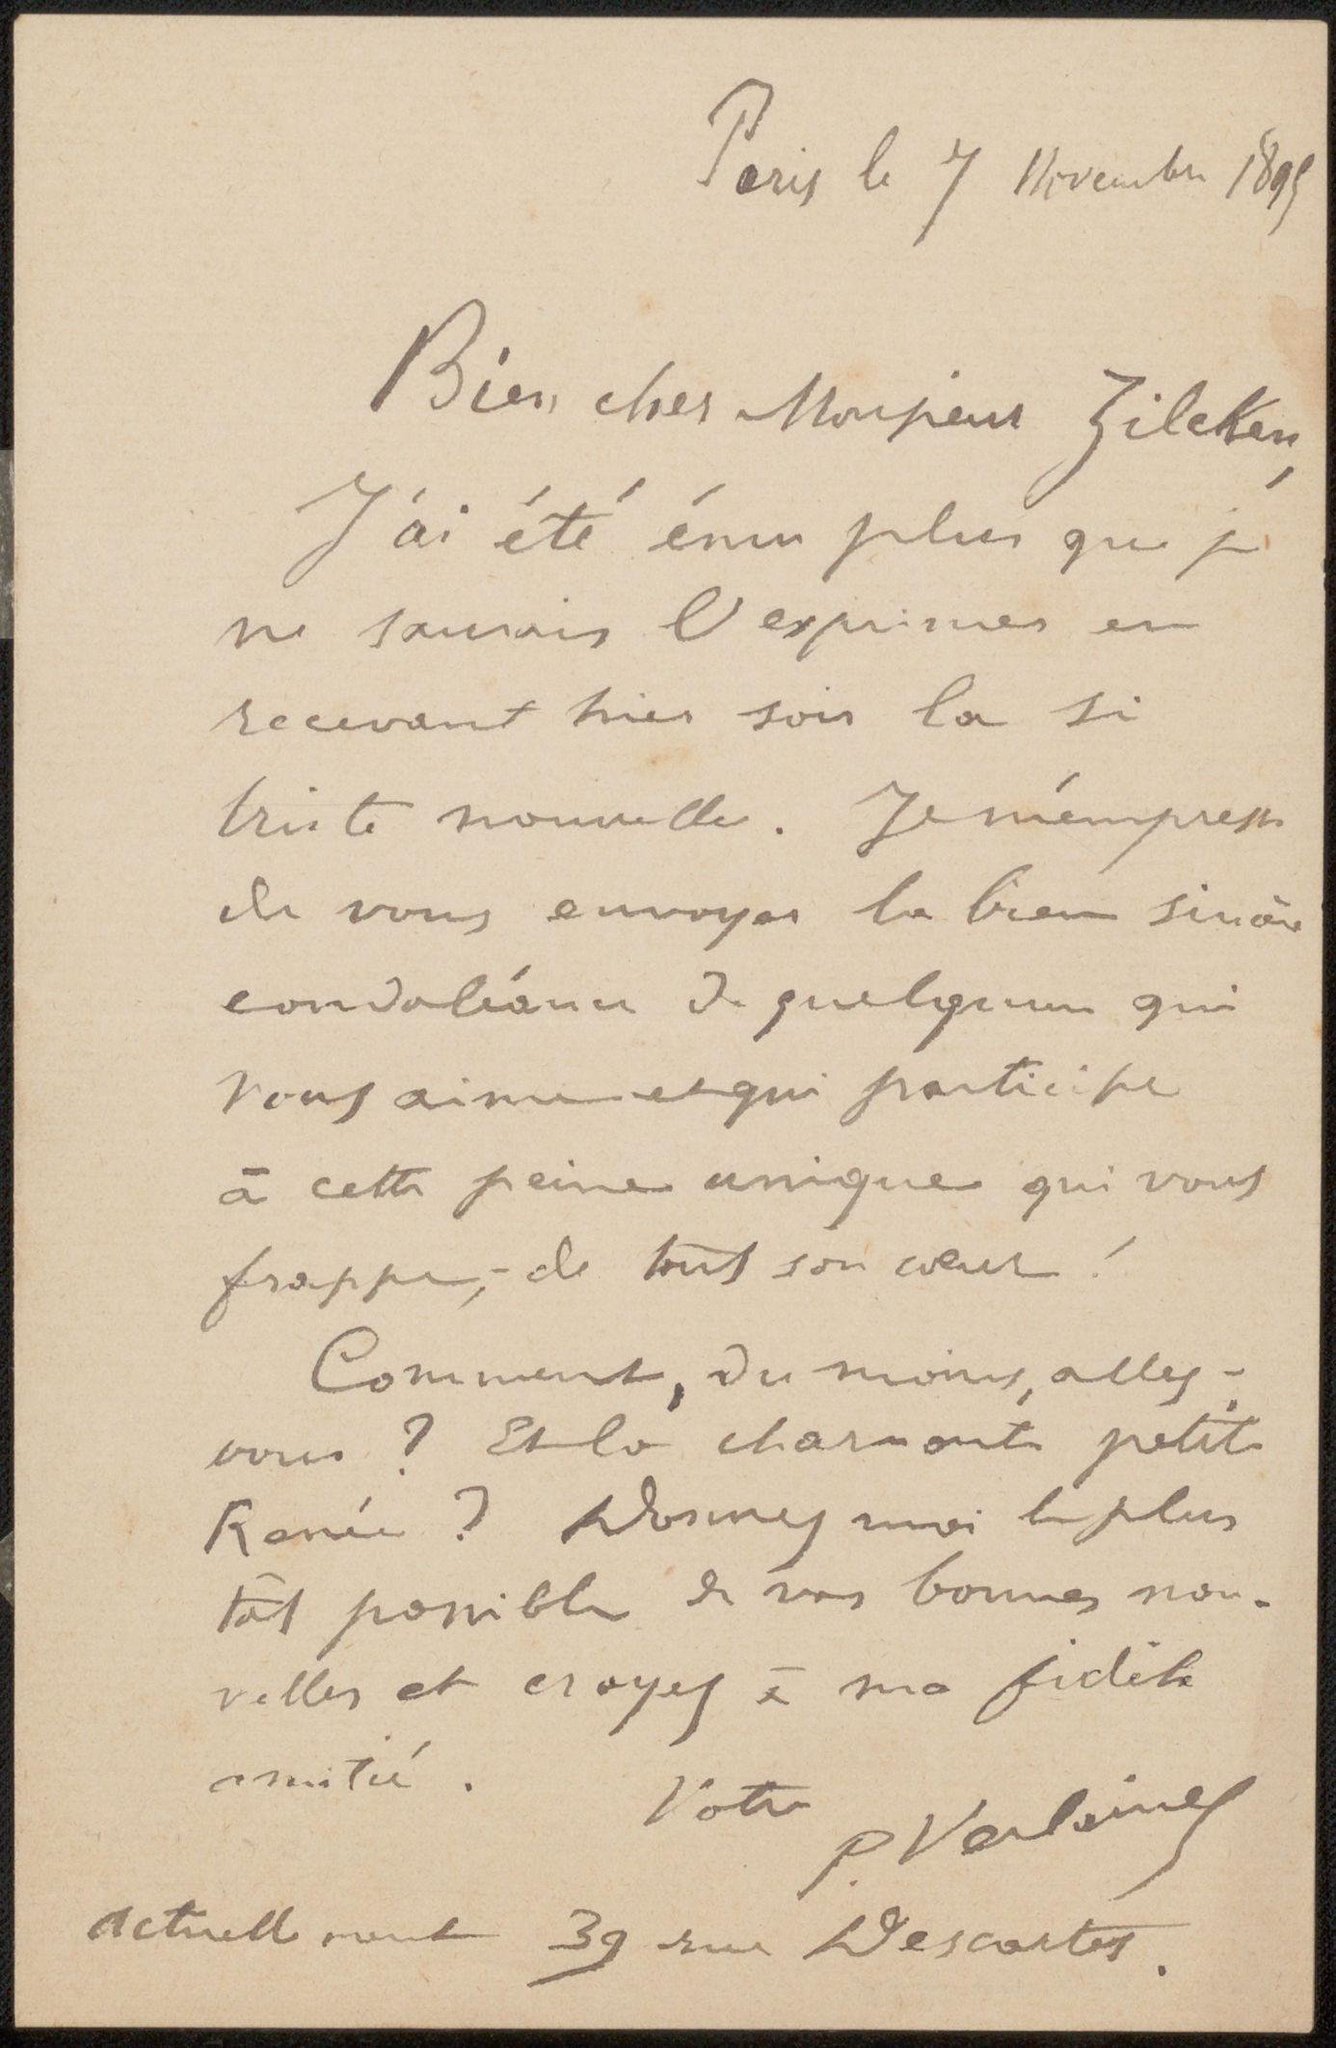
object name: letter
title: Brief aan Philip Zilcken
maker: paul verlaine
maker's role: dichter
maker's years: 1844-1896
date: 1895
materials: ink, paper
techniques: pen, writing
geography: paris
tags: voorburg, print maker, renée hélène laure zilcken, helène lambertine hauzeur, the hague, painter, draughtsman, philip zilcken, passions, emotions, affections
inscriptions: watermark